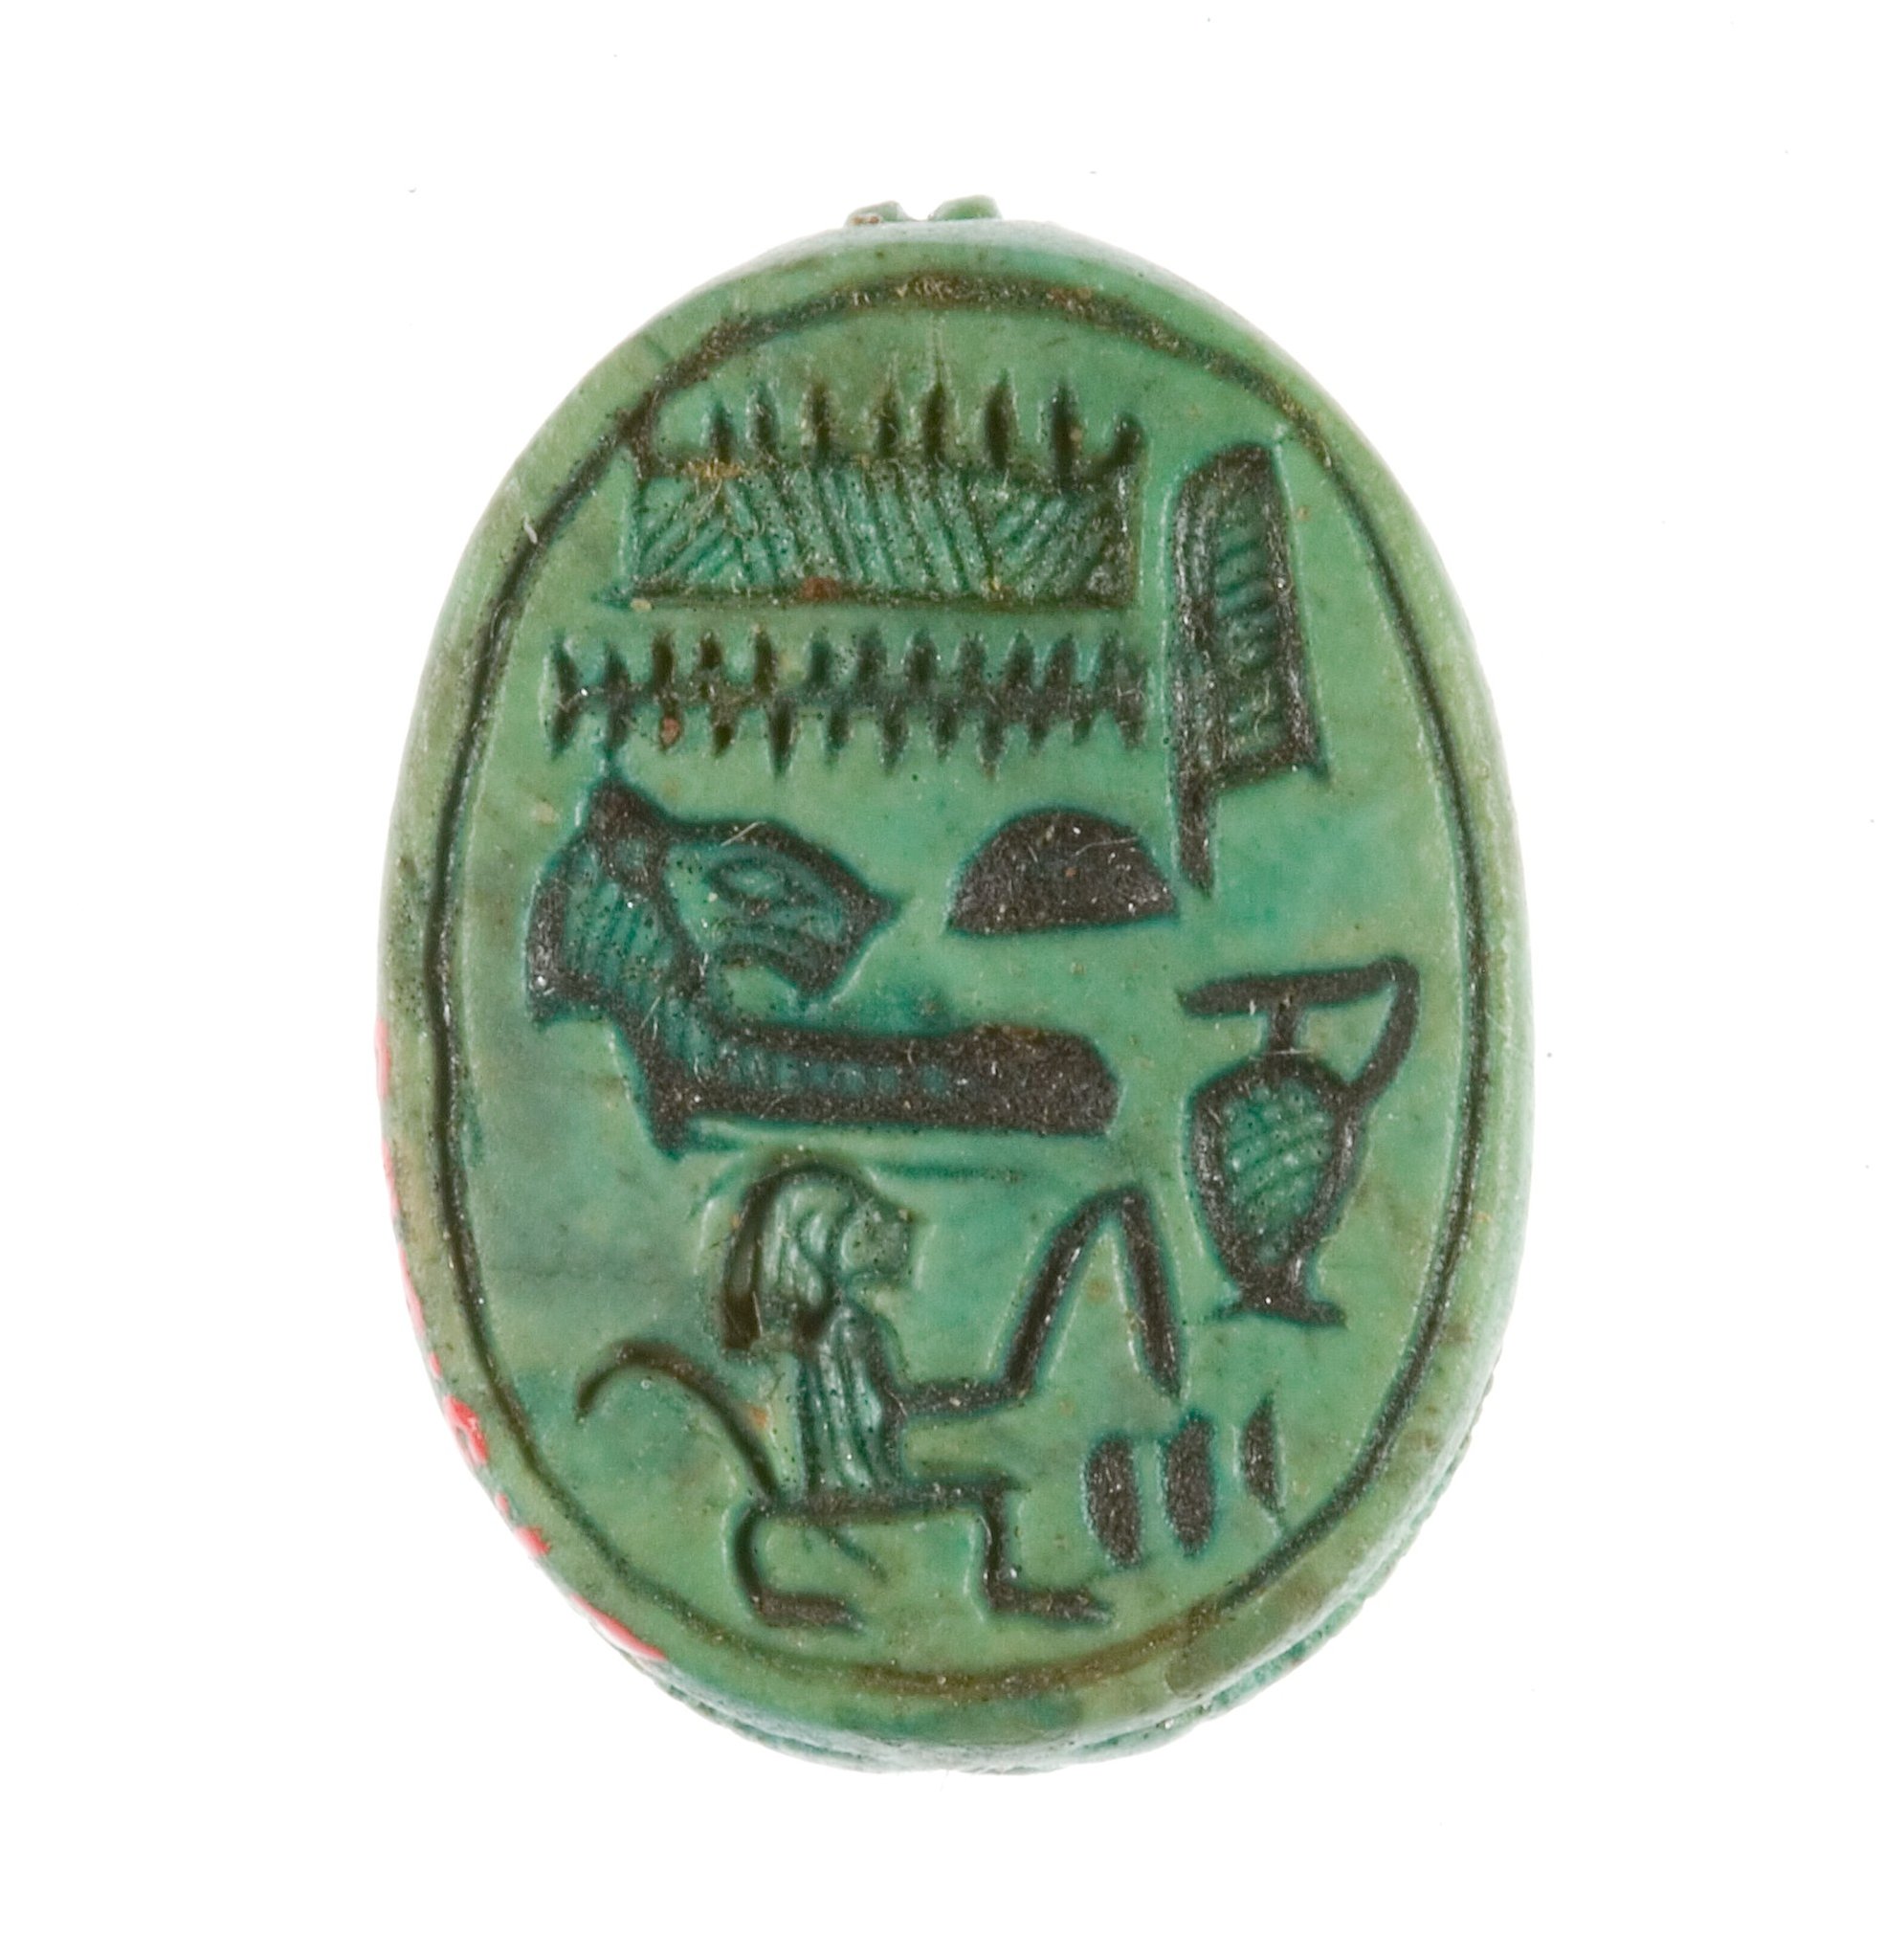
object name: scarab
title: Scarab Inscribed Hatshepsut United with Amun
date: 1479-1458 BCE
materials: stone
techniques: glazing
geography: egypt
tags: hieroglyphs,scarabs